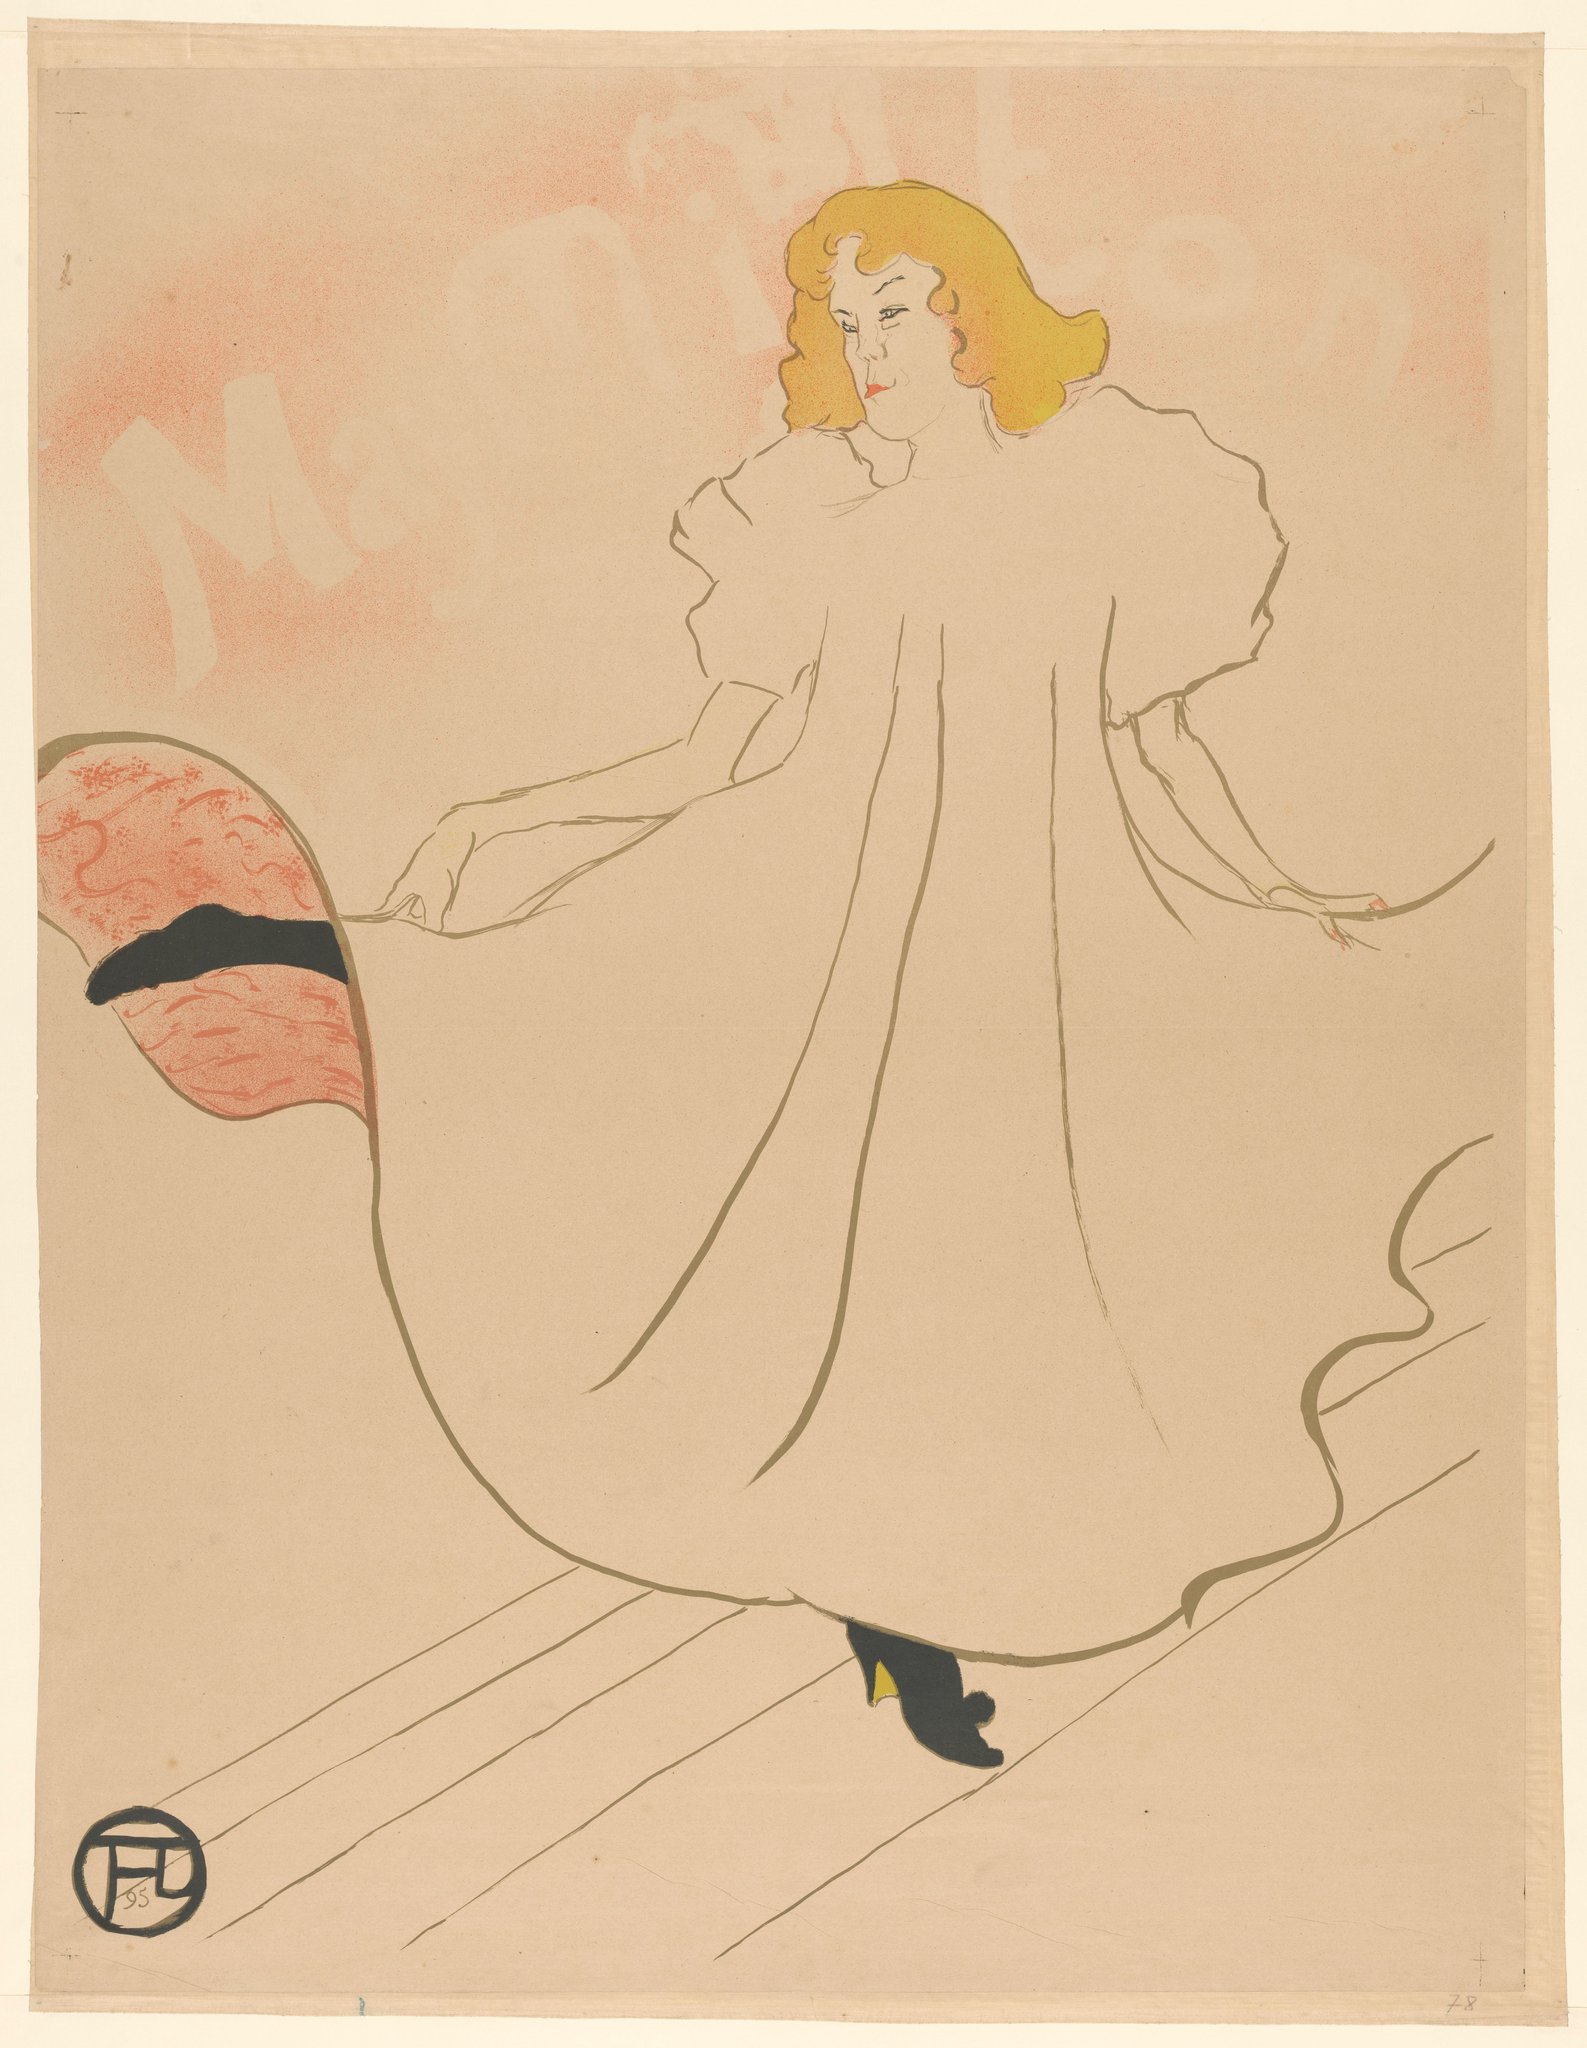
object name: poster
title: May Milton dansend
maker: henri de toulouse-lautrec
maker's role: draughtsman, painter, print maker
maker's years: 1864-1901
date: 1874-1901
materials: paper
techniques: lithograph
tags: woman dancing alone